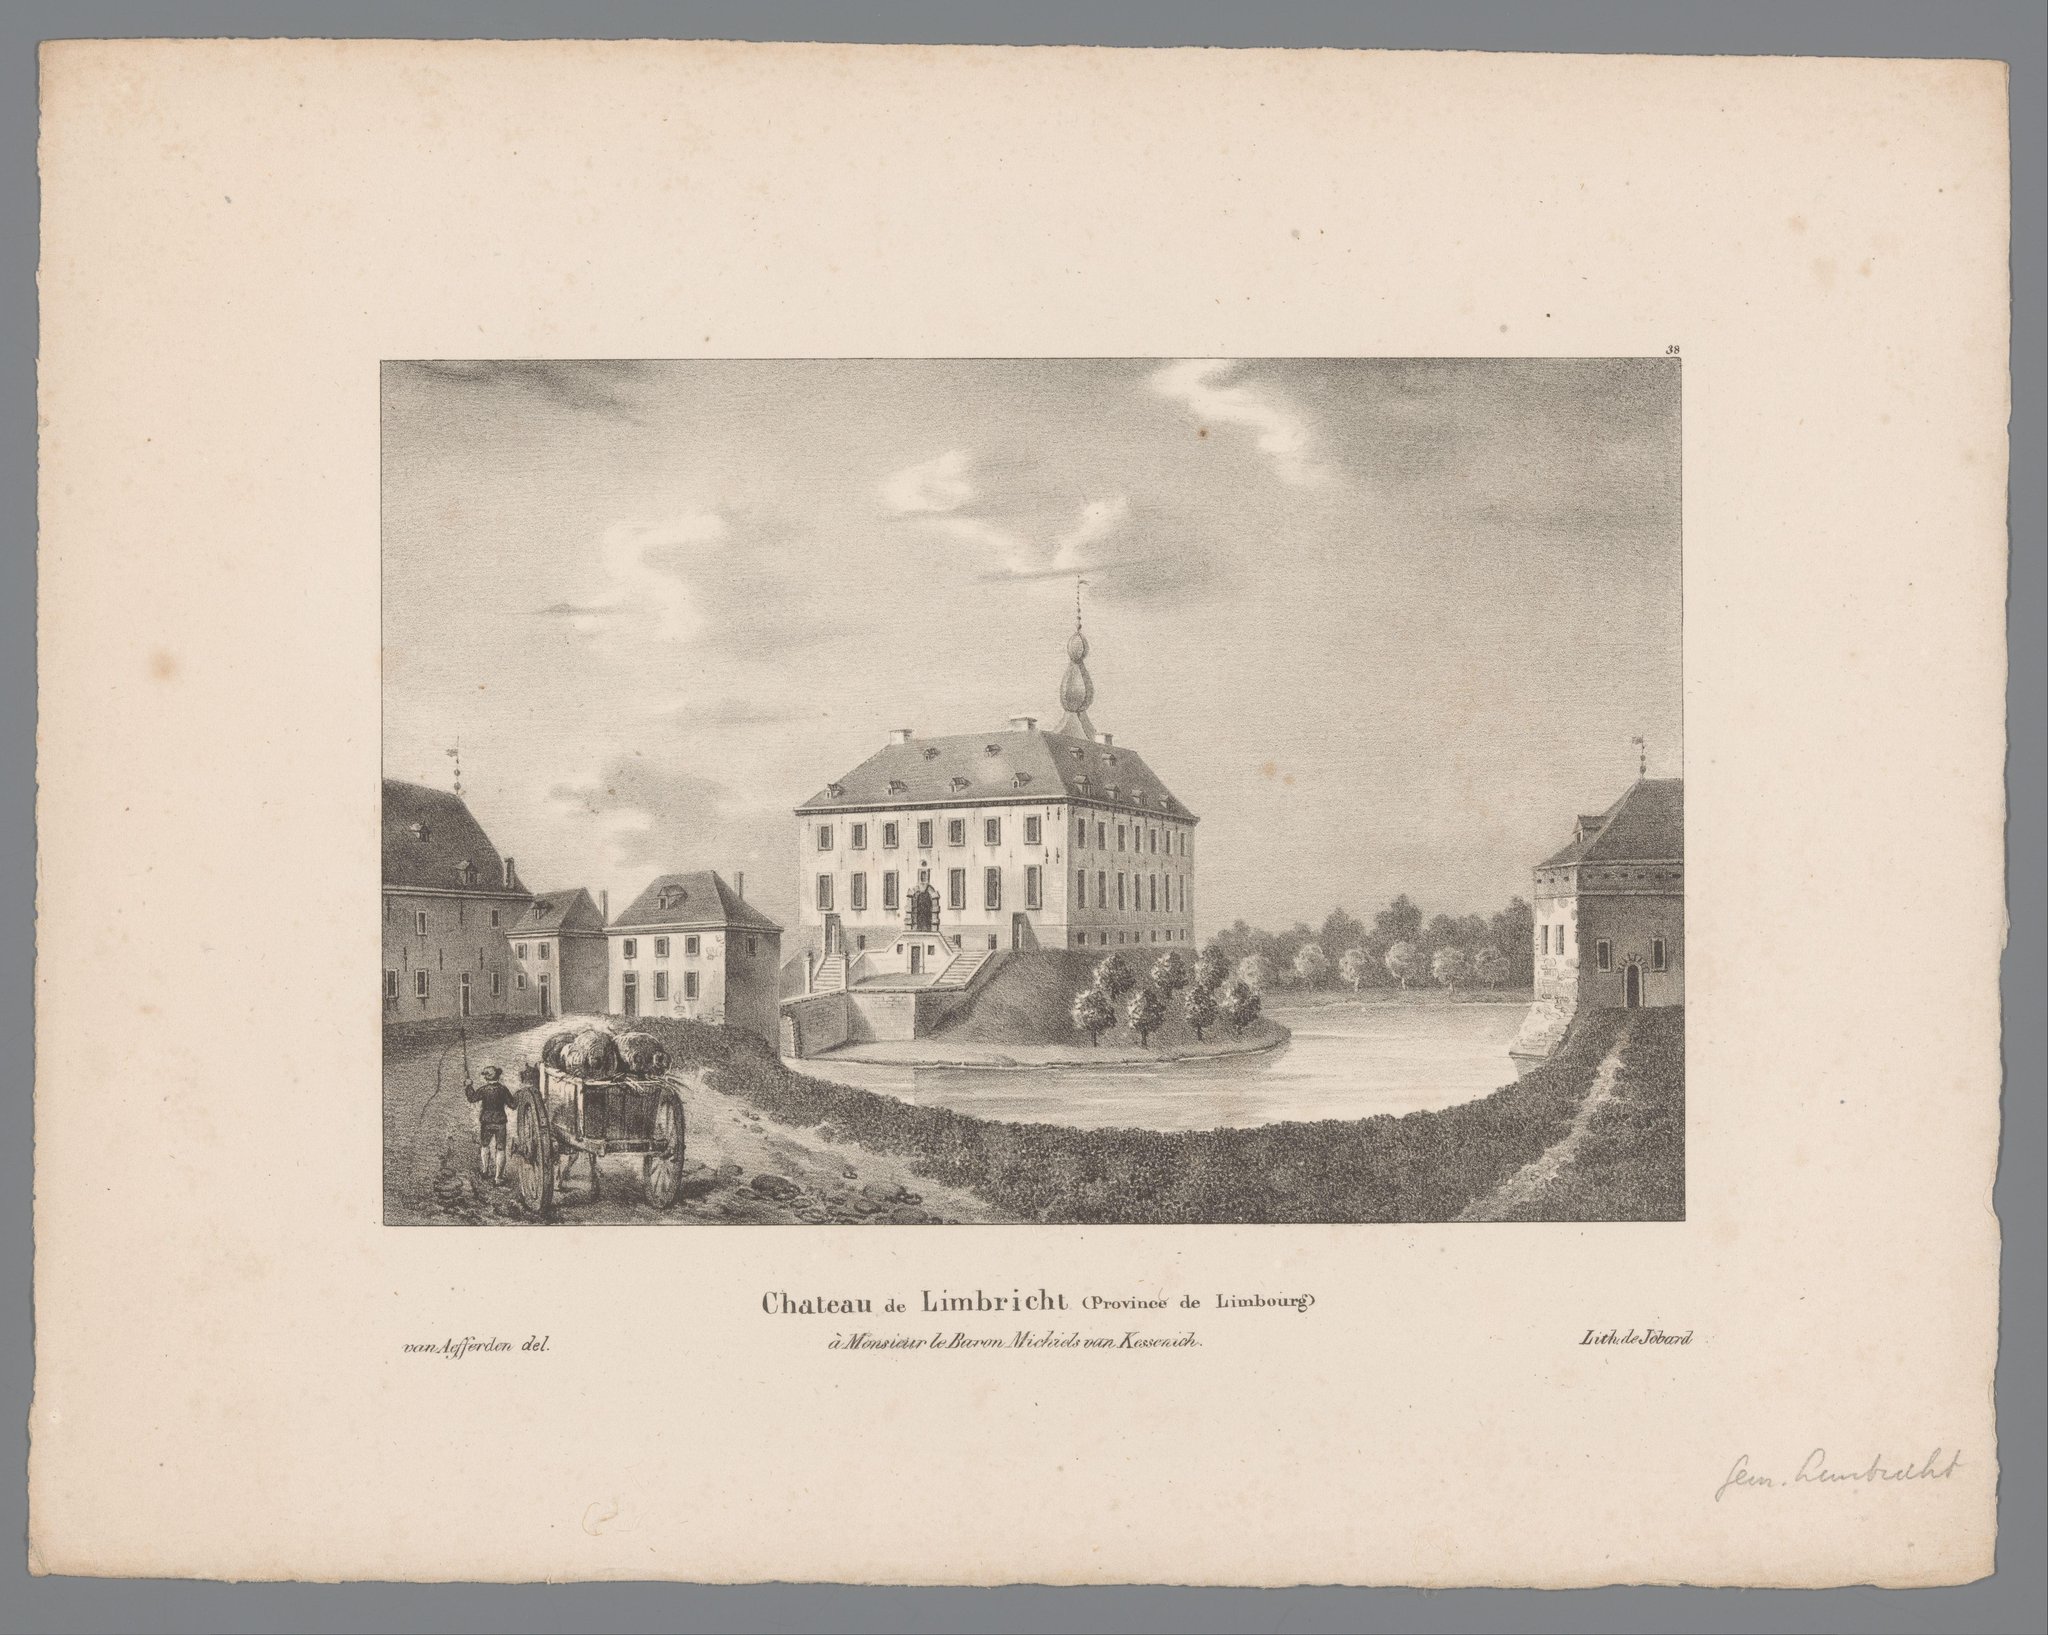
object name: print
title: Gezicht op Kasteel Limbricht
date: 1820-1850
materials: paper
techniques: lithograph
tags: castle